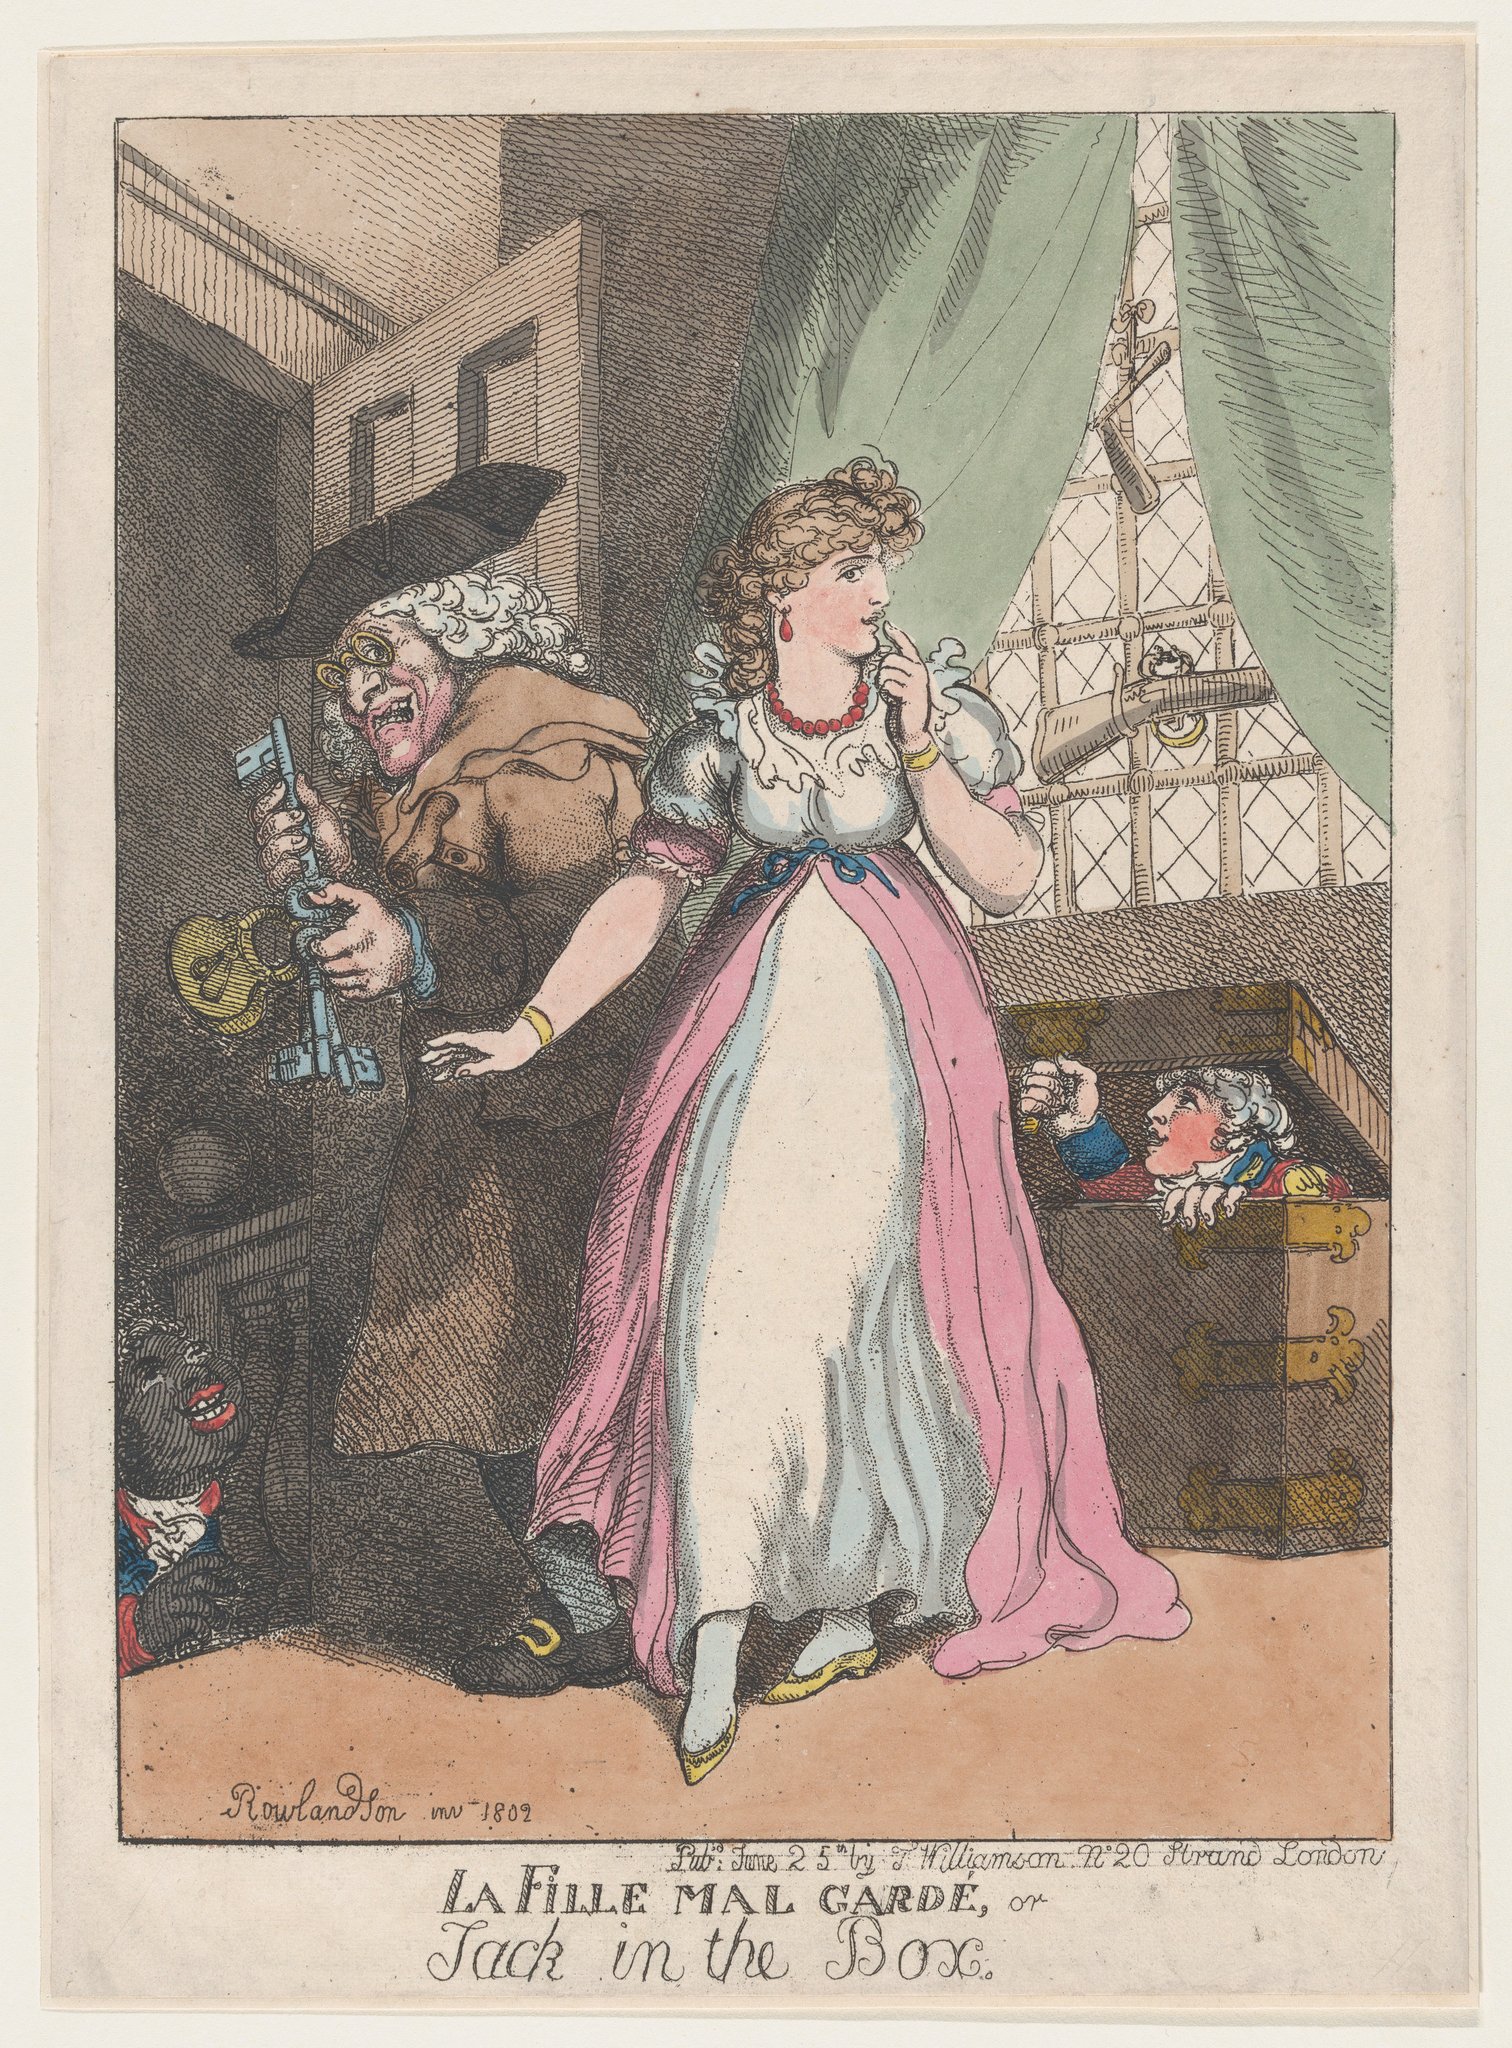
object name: print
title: La Fille Mal Gardé, or Jack in the Box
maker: thomas rowlandson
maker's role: artist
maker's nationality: british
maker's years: 1757-1827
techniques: etching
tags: satire,men,women